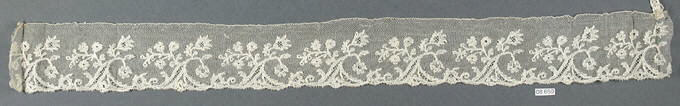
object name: strip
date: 1750-1850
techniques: lace